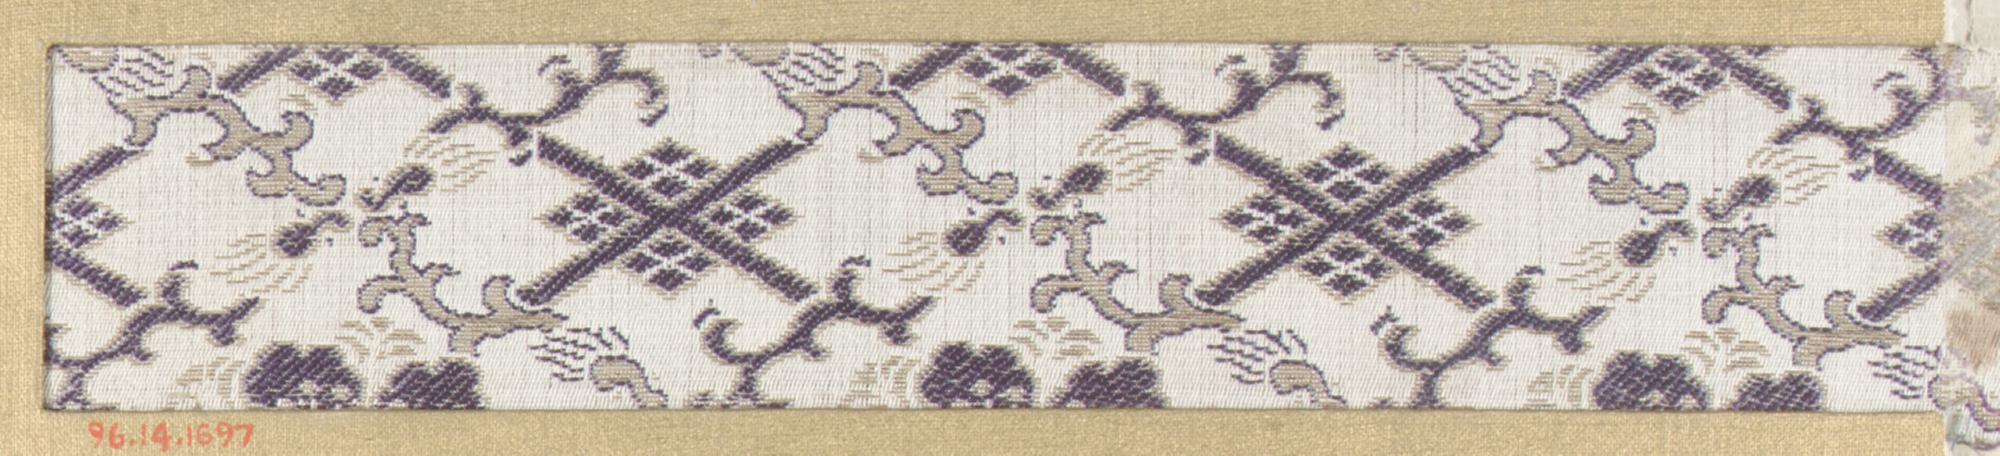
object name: piece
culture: japanese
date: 1701-1900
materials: silk